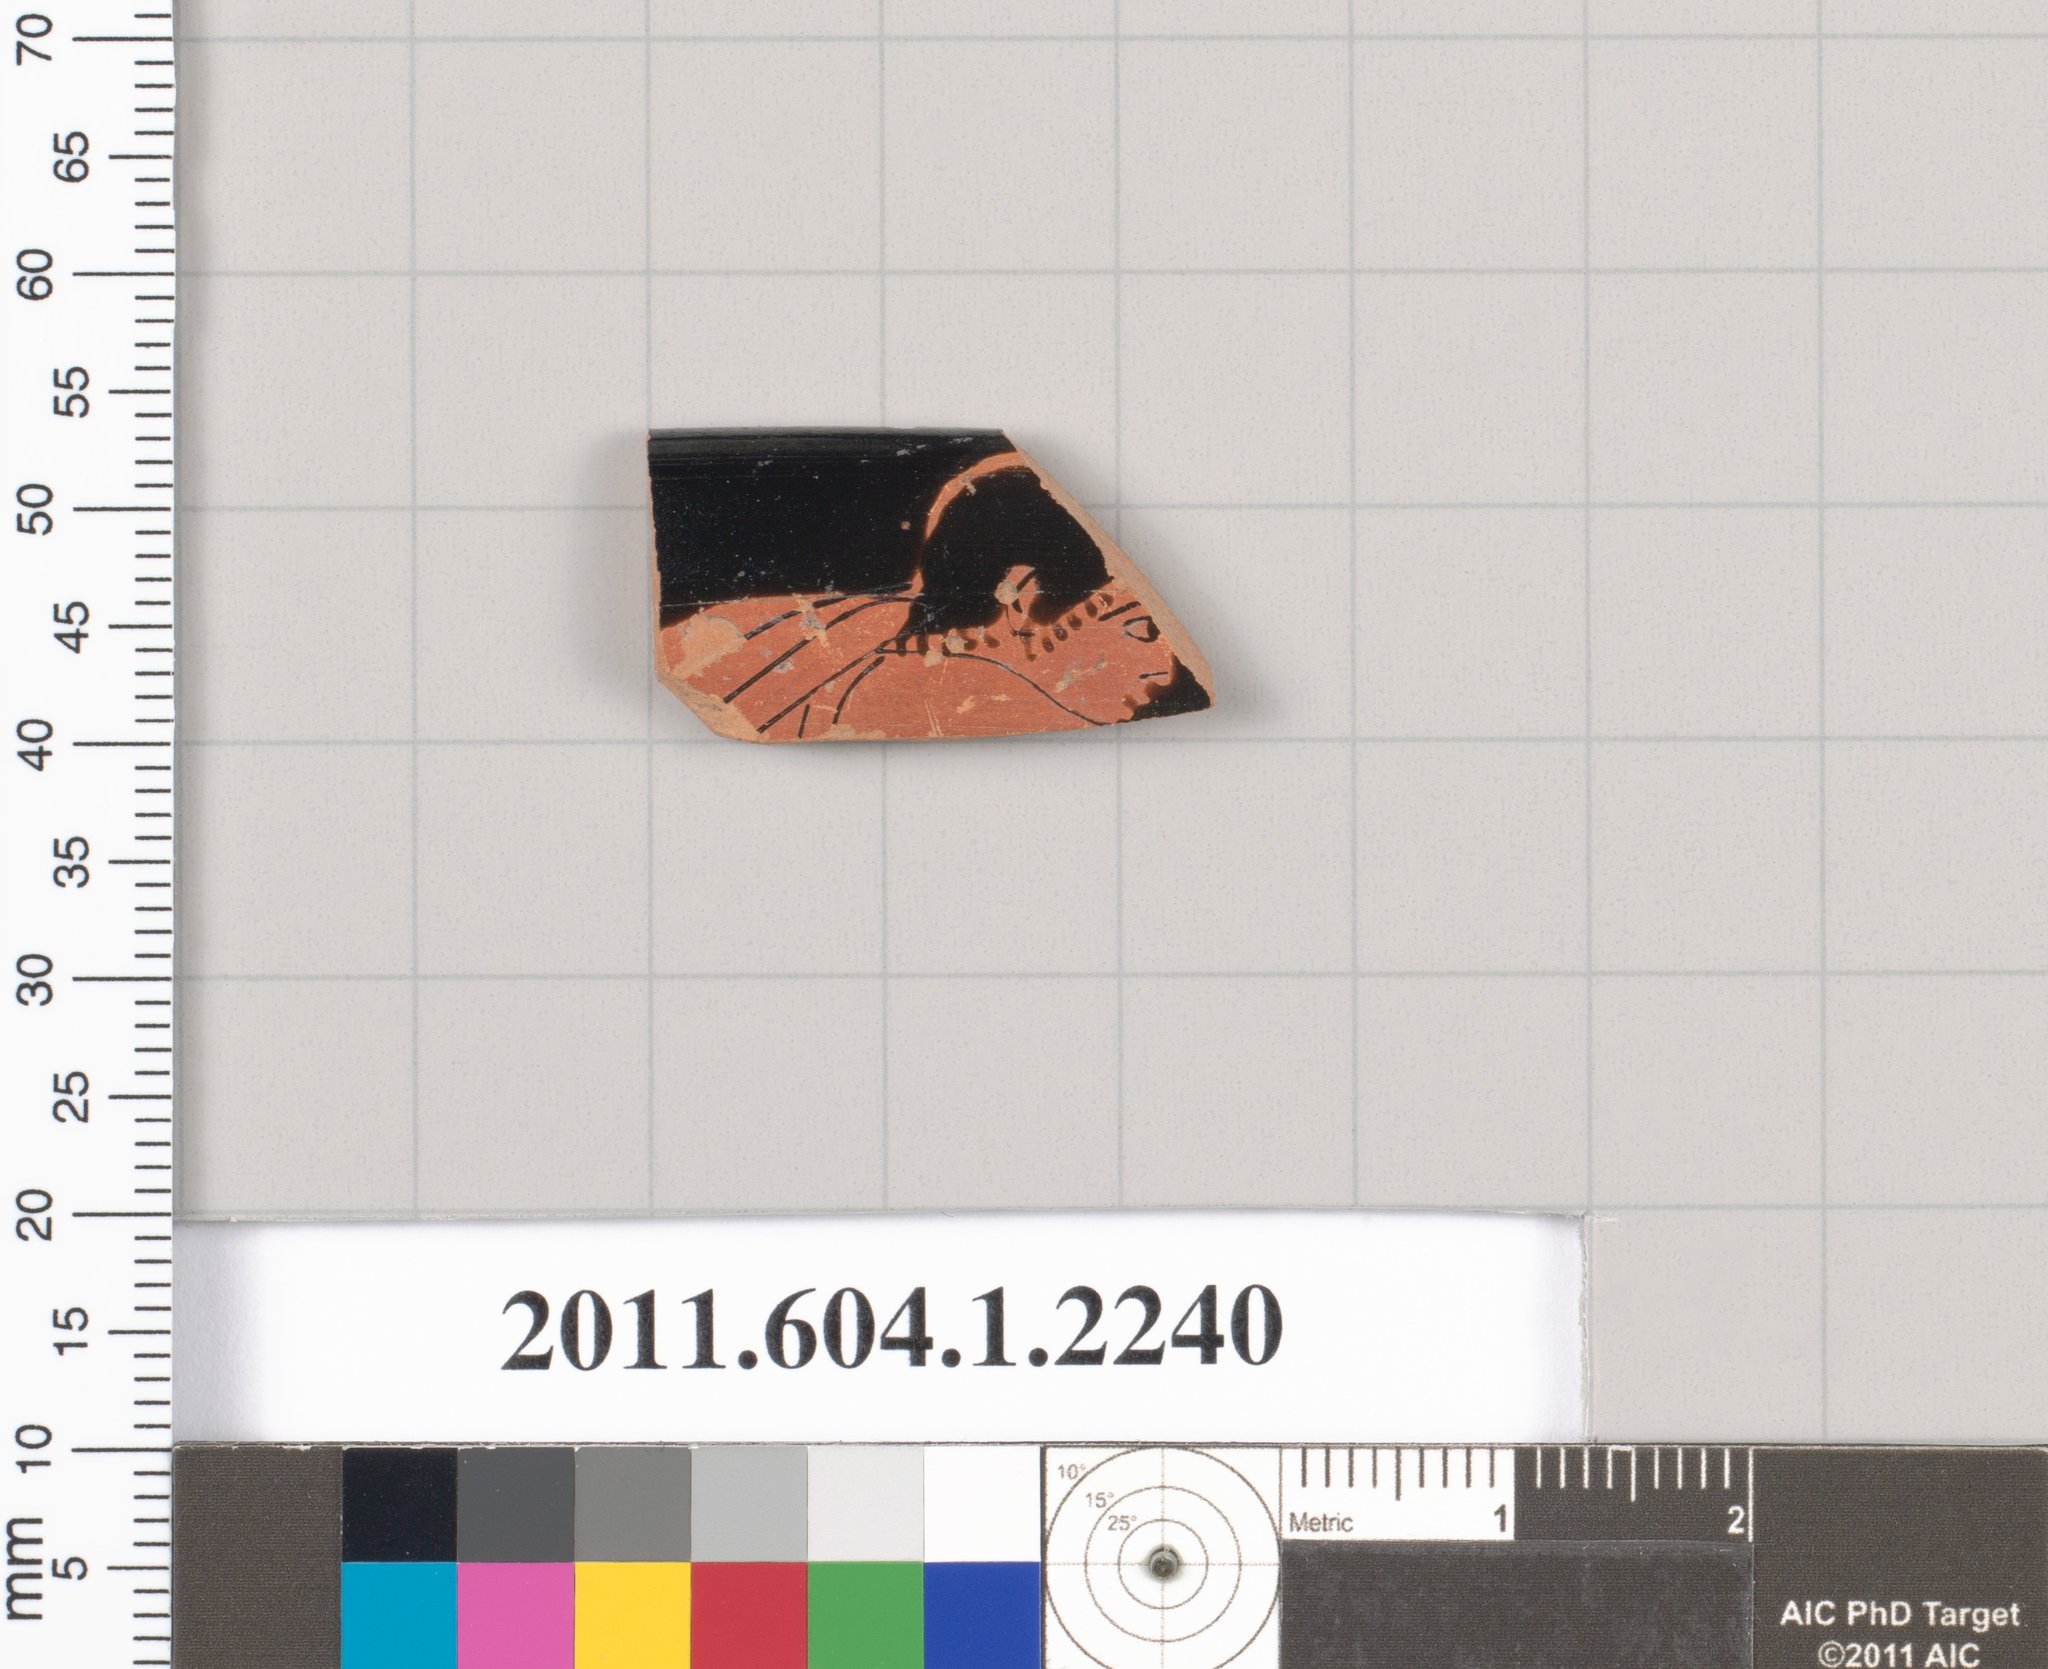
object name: kylix fragment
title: Terracotta rim fragment of a kylix (drinking cup)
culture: greek, attic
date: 475-451 BCE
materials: terracotta